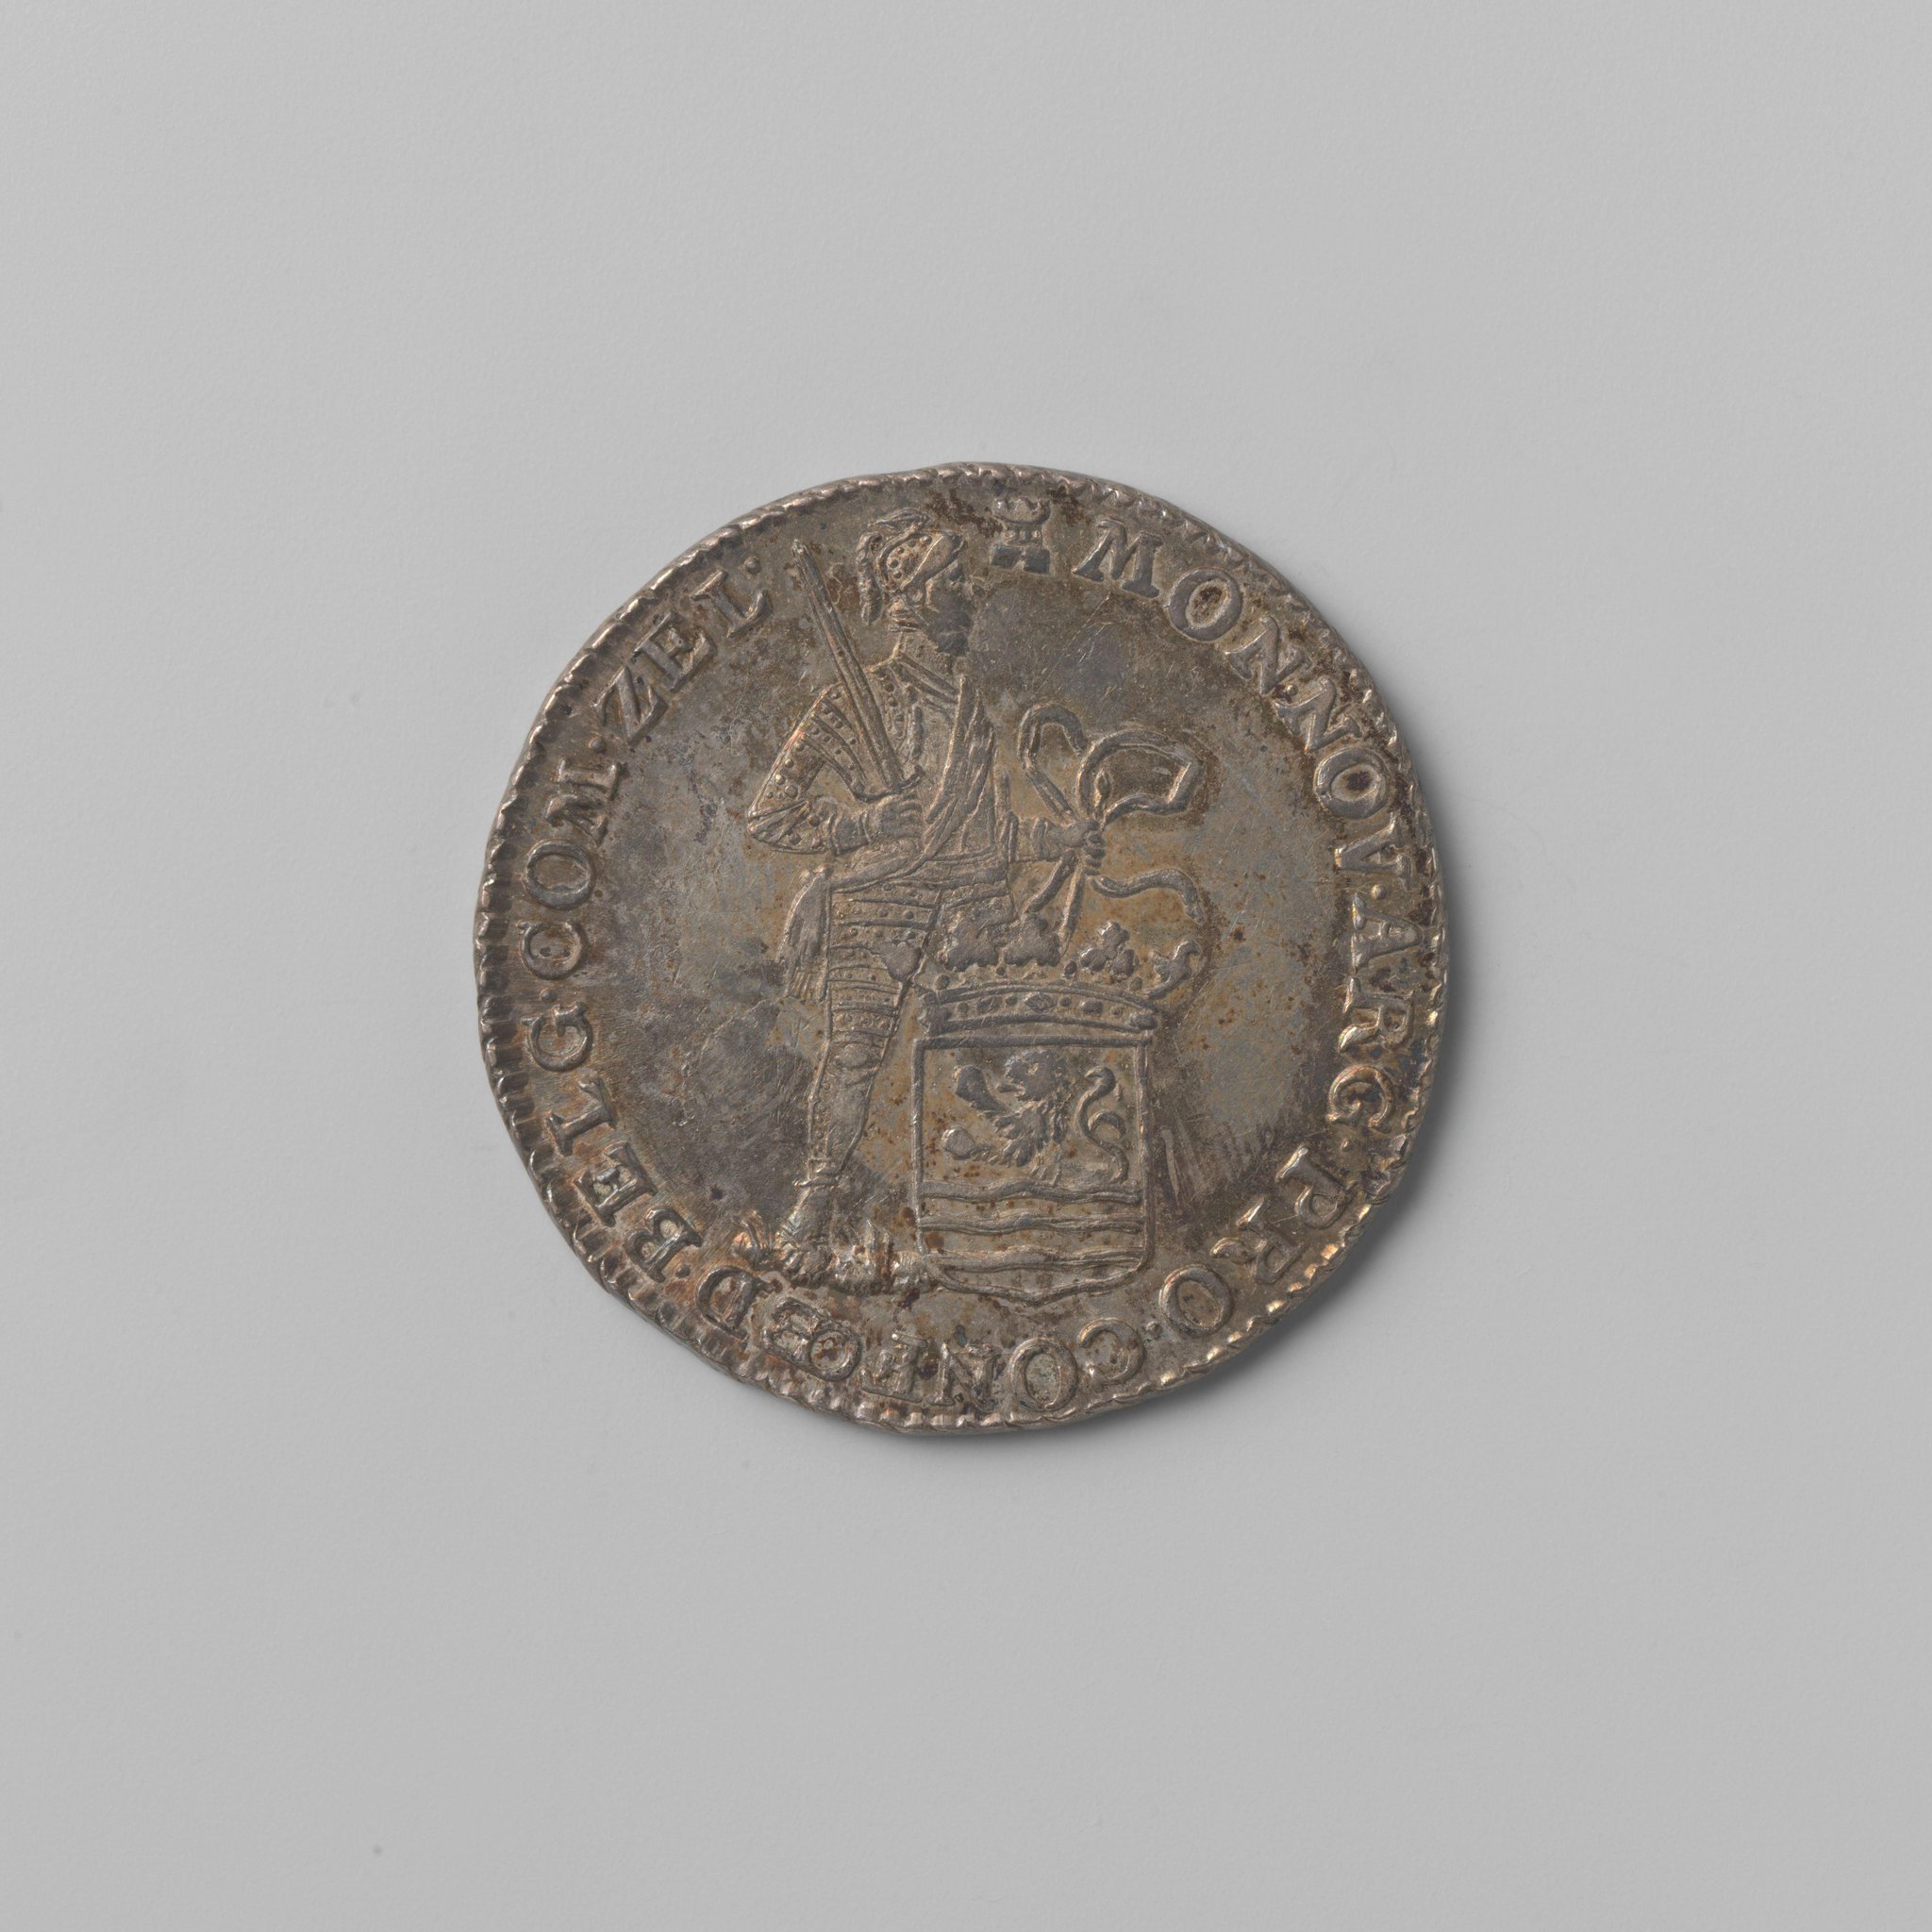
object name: coin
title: Zeeland, halve zilveren dukaat, 1792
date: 1792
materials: silver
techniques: striking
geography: middelburg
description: Zilveren munt. Voorzijde: staande geharnaste ridder naar rechts met zwaard in rechterhand en gekroond wapenschild van Zeeland aan lint in linkerhand. Keerzijde: tussen jaartal gekroond generaliteitswapenschild. Kabelrand.